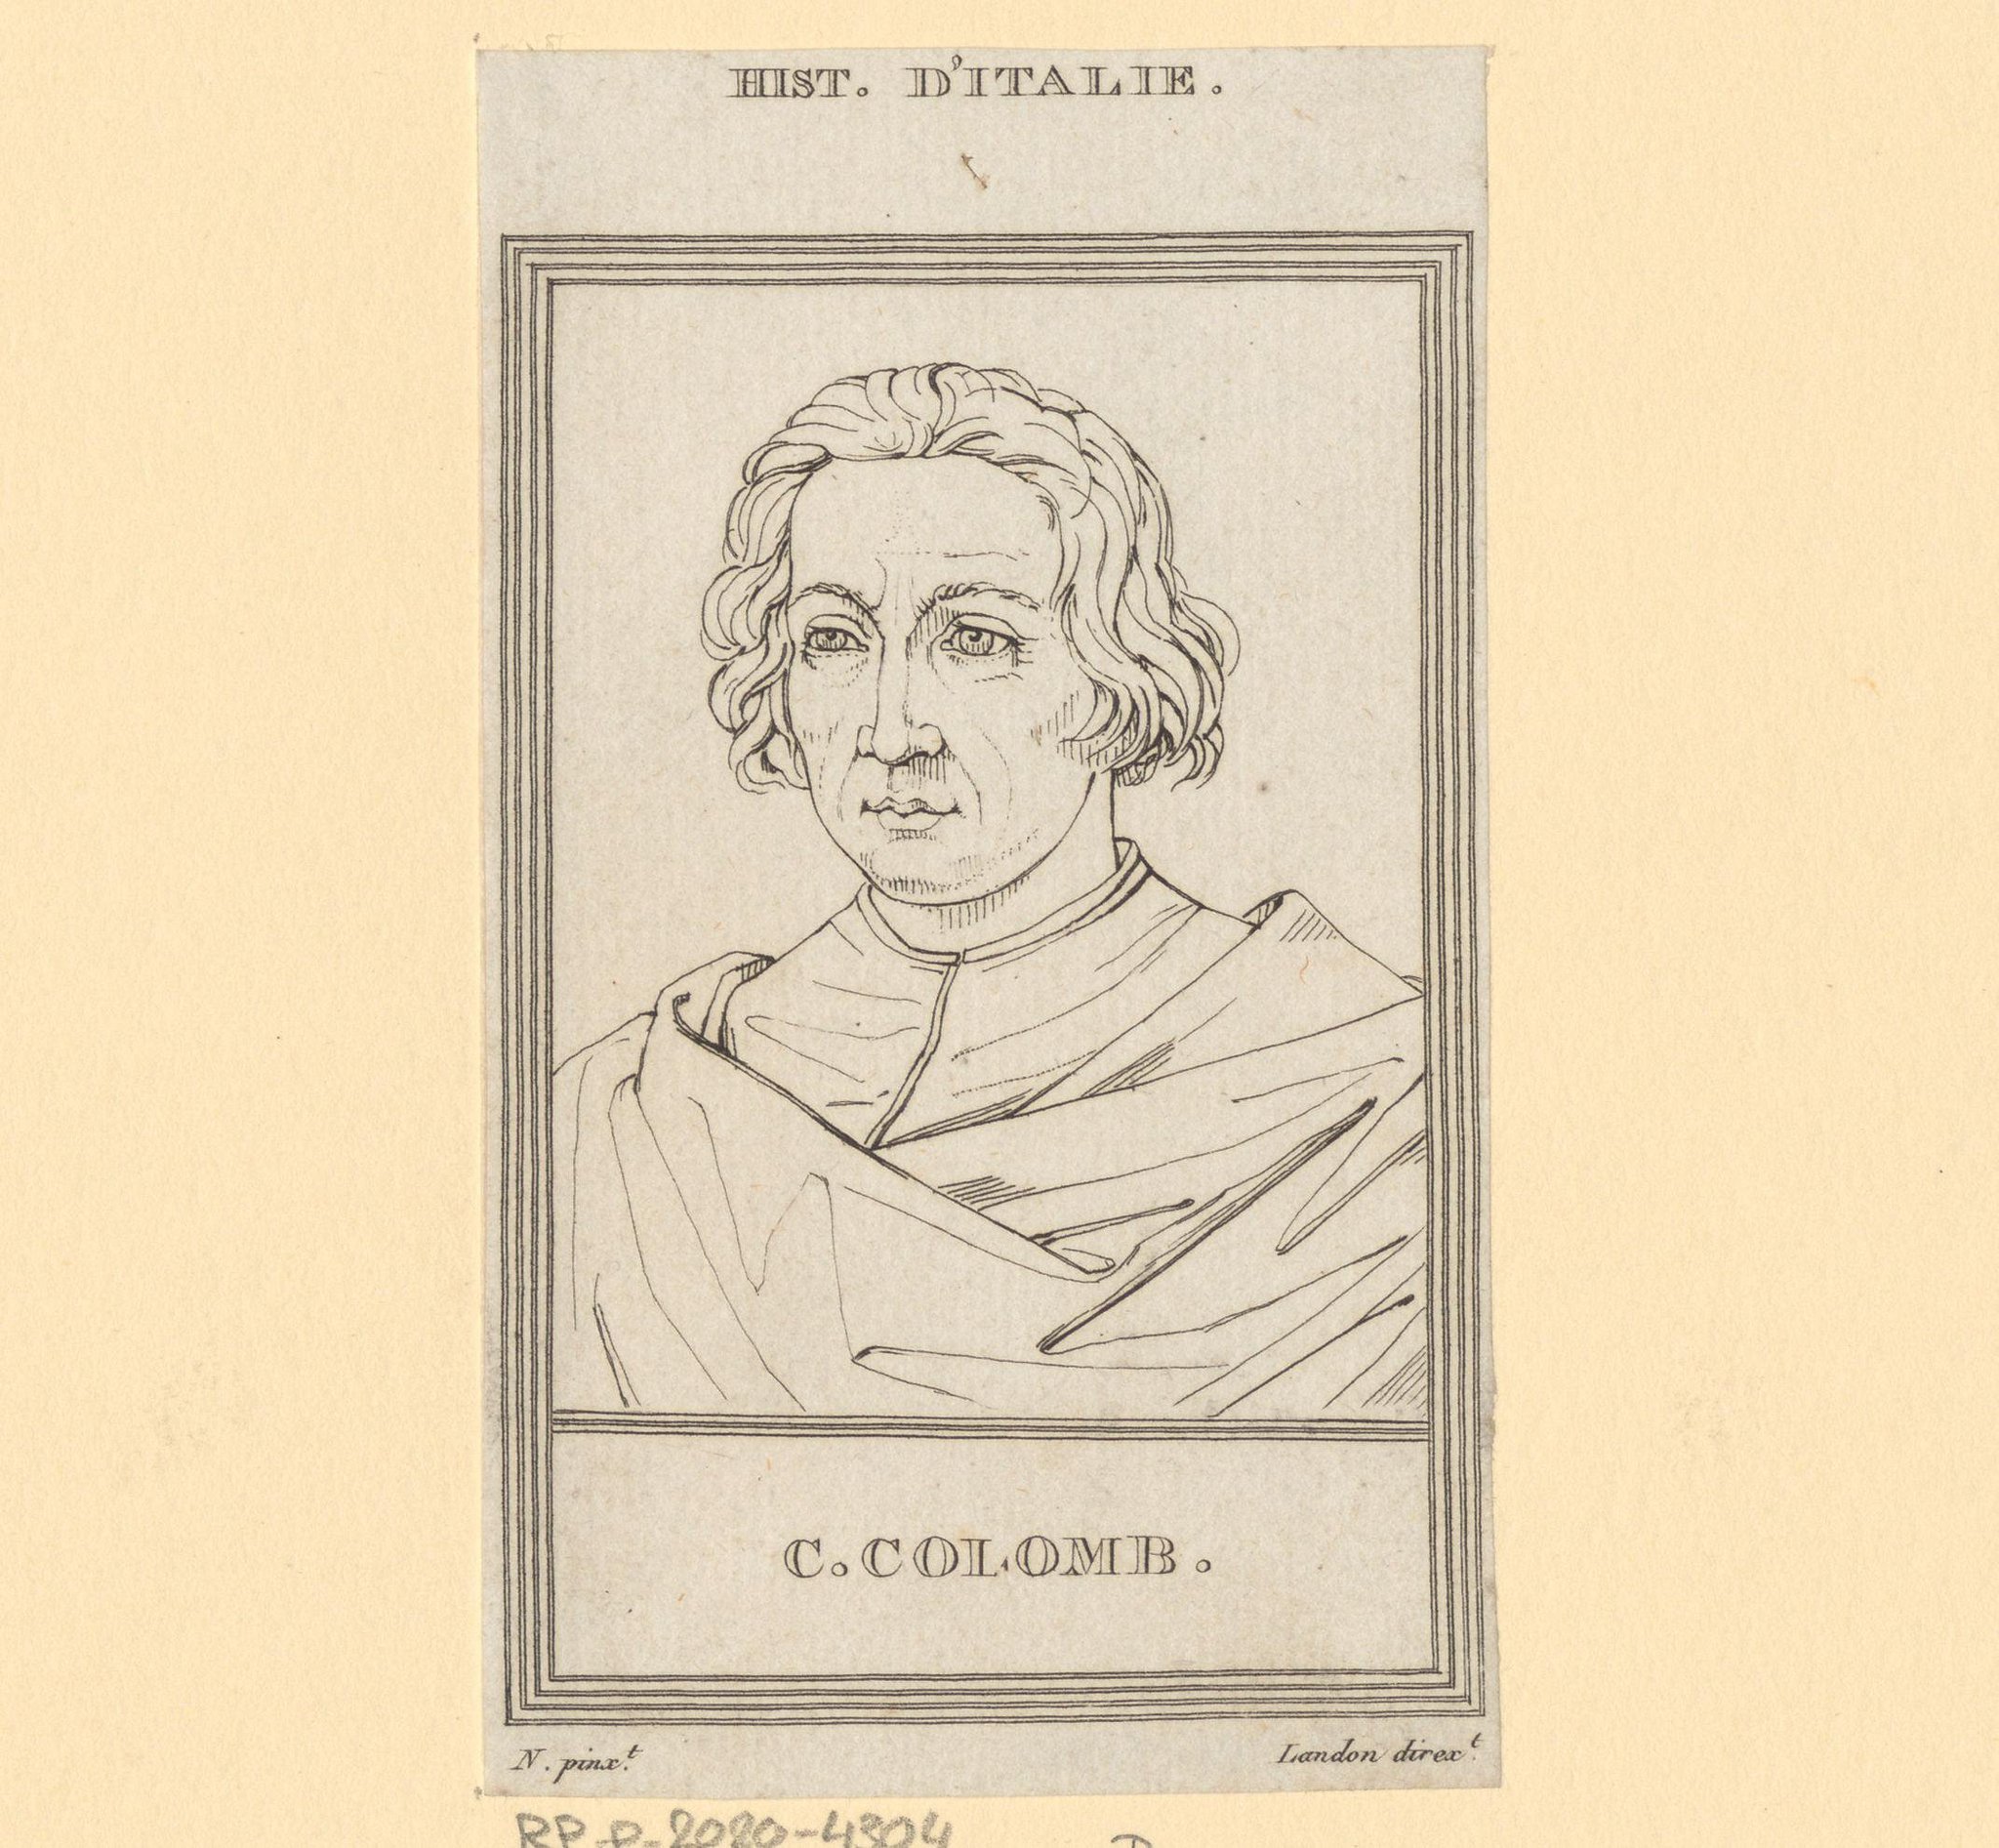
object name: print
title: Portret van Christoffel Columbus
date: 1805-1811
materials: paper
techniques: engraving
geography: paris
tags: historical persons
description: Prent mogelijk uit: Galerie historique des hommes les plus célèbres (...). Parijs: Charles Paul Landon, 1805-1811.